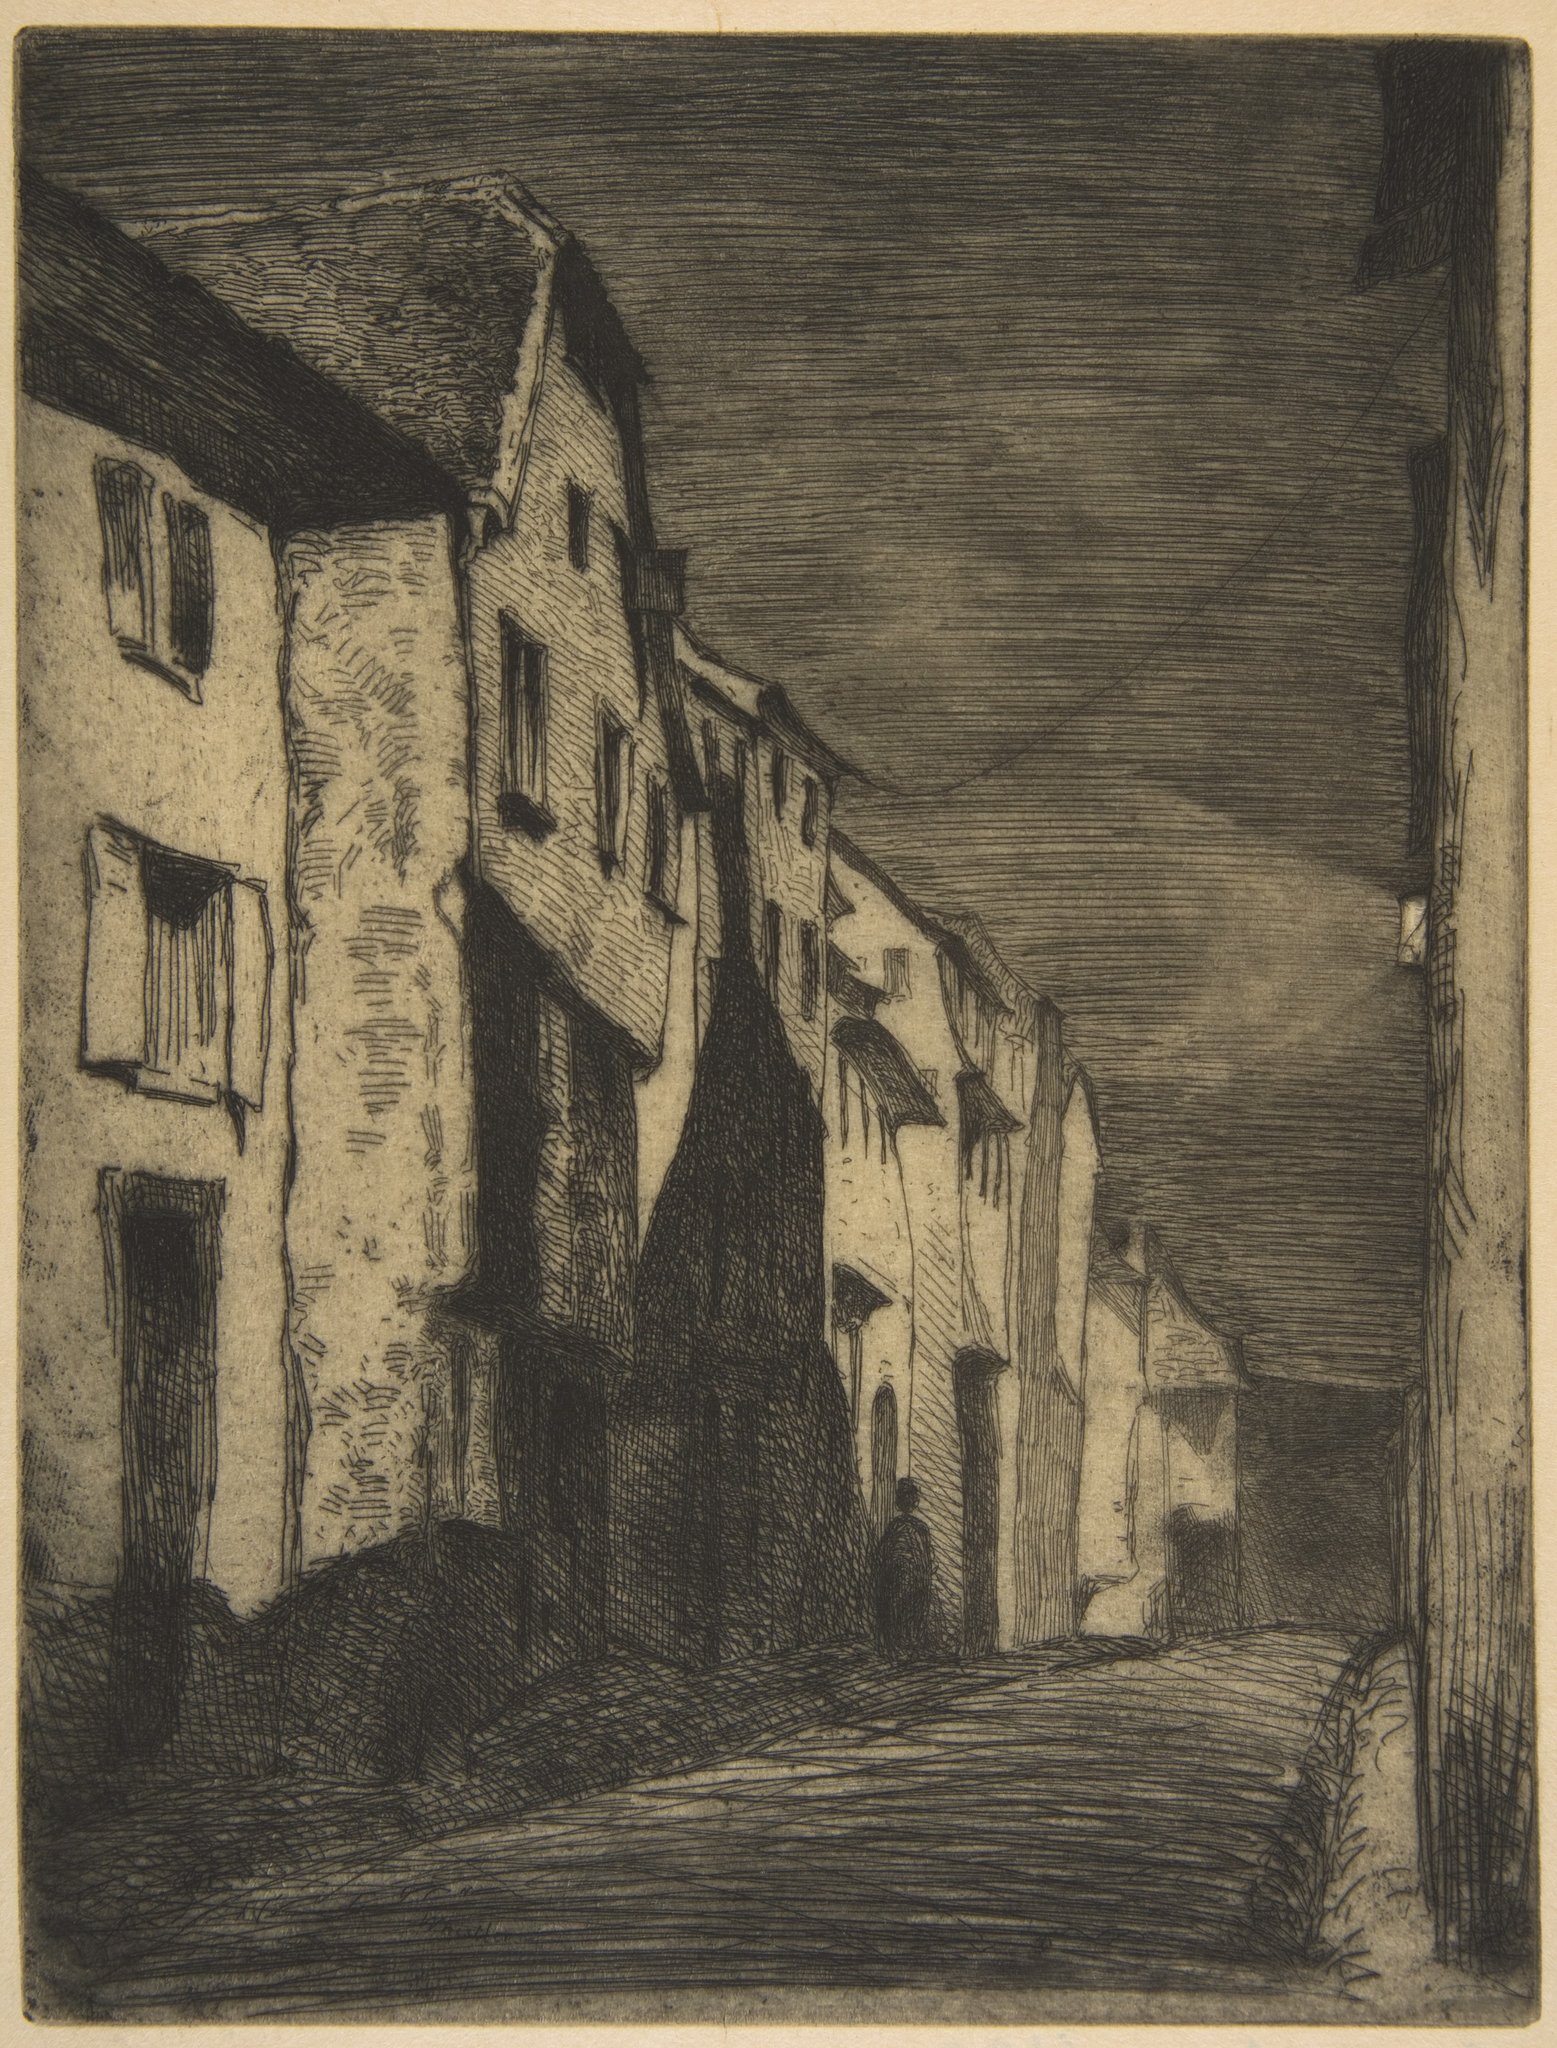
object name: print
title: Street at Saverne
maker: james mcneill whistler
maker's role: artist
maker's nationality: american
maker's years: 1834-1903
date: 1858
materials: ink, paper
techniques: etching, printing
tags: buildings,streets